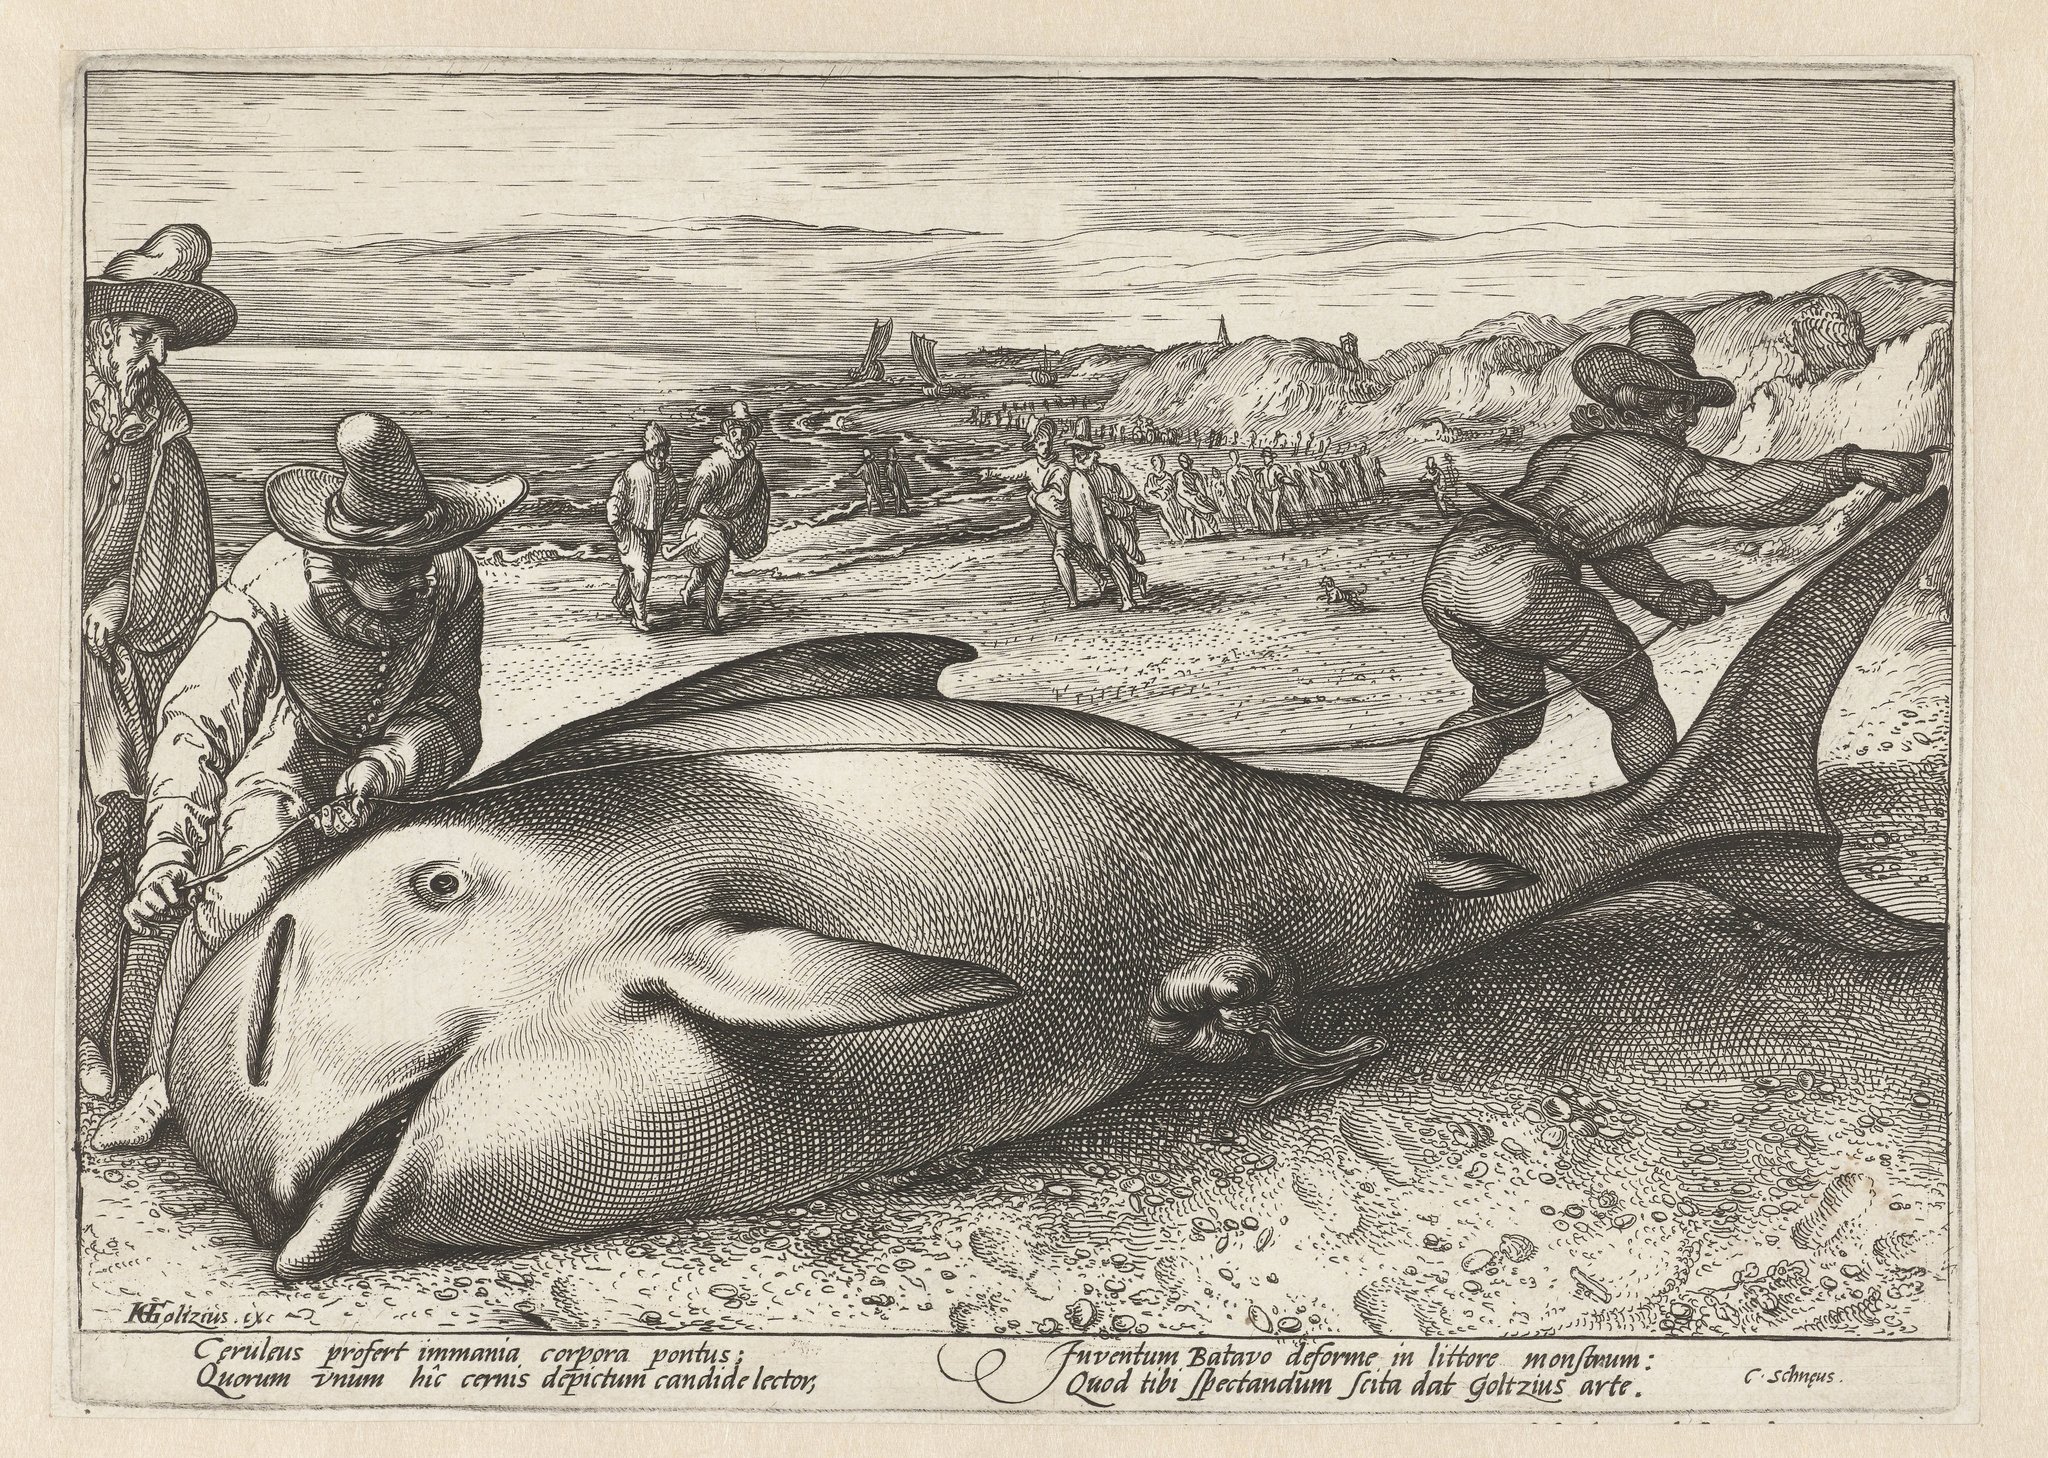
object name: print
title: Twee mannen meten een gestrande walvis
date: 1594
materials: paper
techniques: engraving, etching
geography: haarlem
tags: swimming mammals: whale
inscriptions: collector's mark: Lugt 240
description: Twee mannen meten met een koord de lengte van een walvis die op het strand ligt. Op de achtergrond komt een stoet mensen aangelopen. Onder de voorstelling vier regels Latijn.